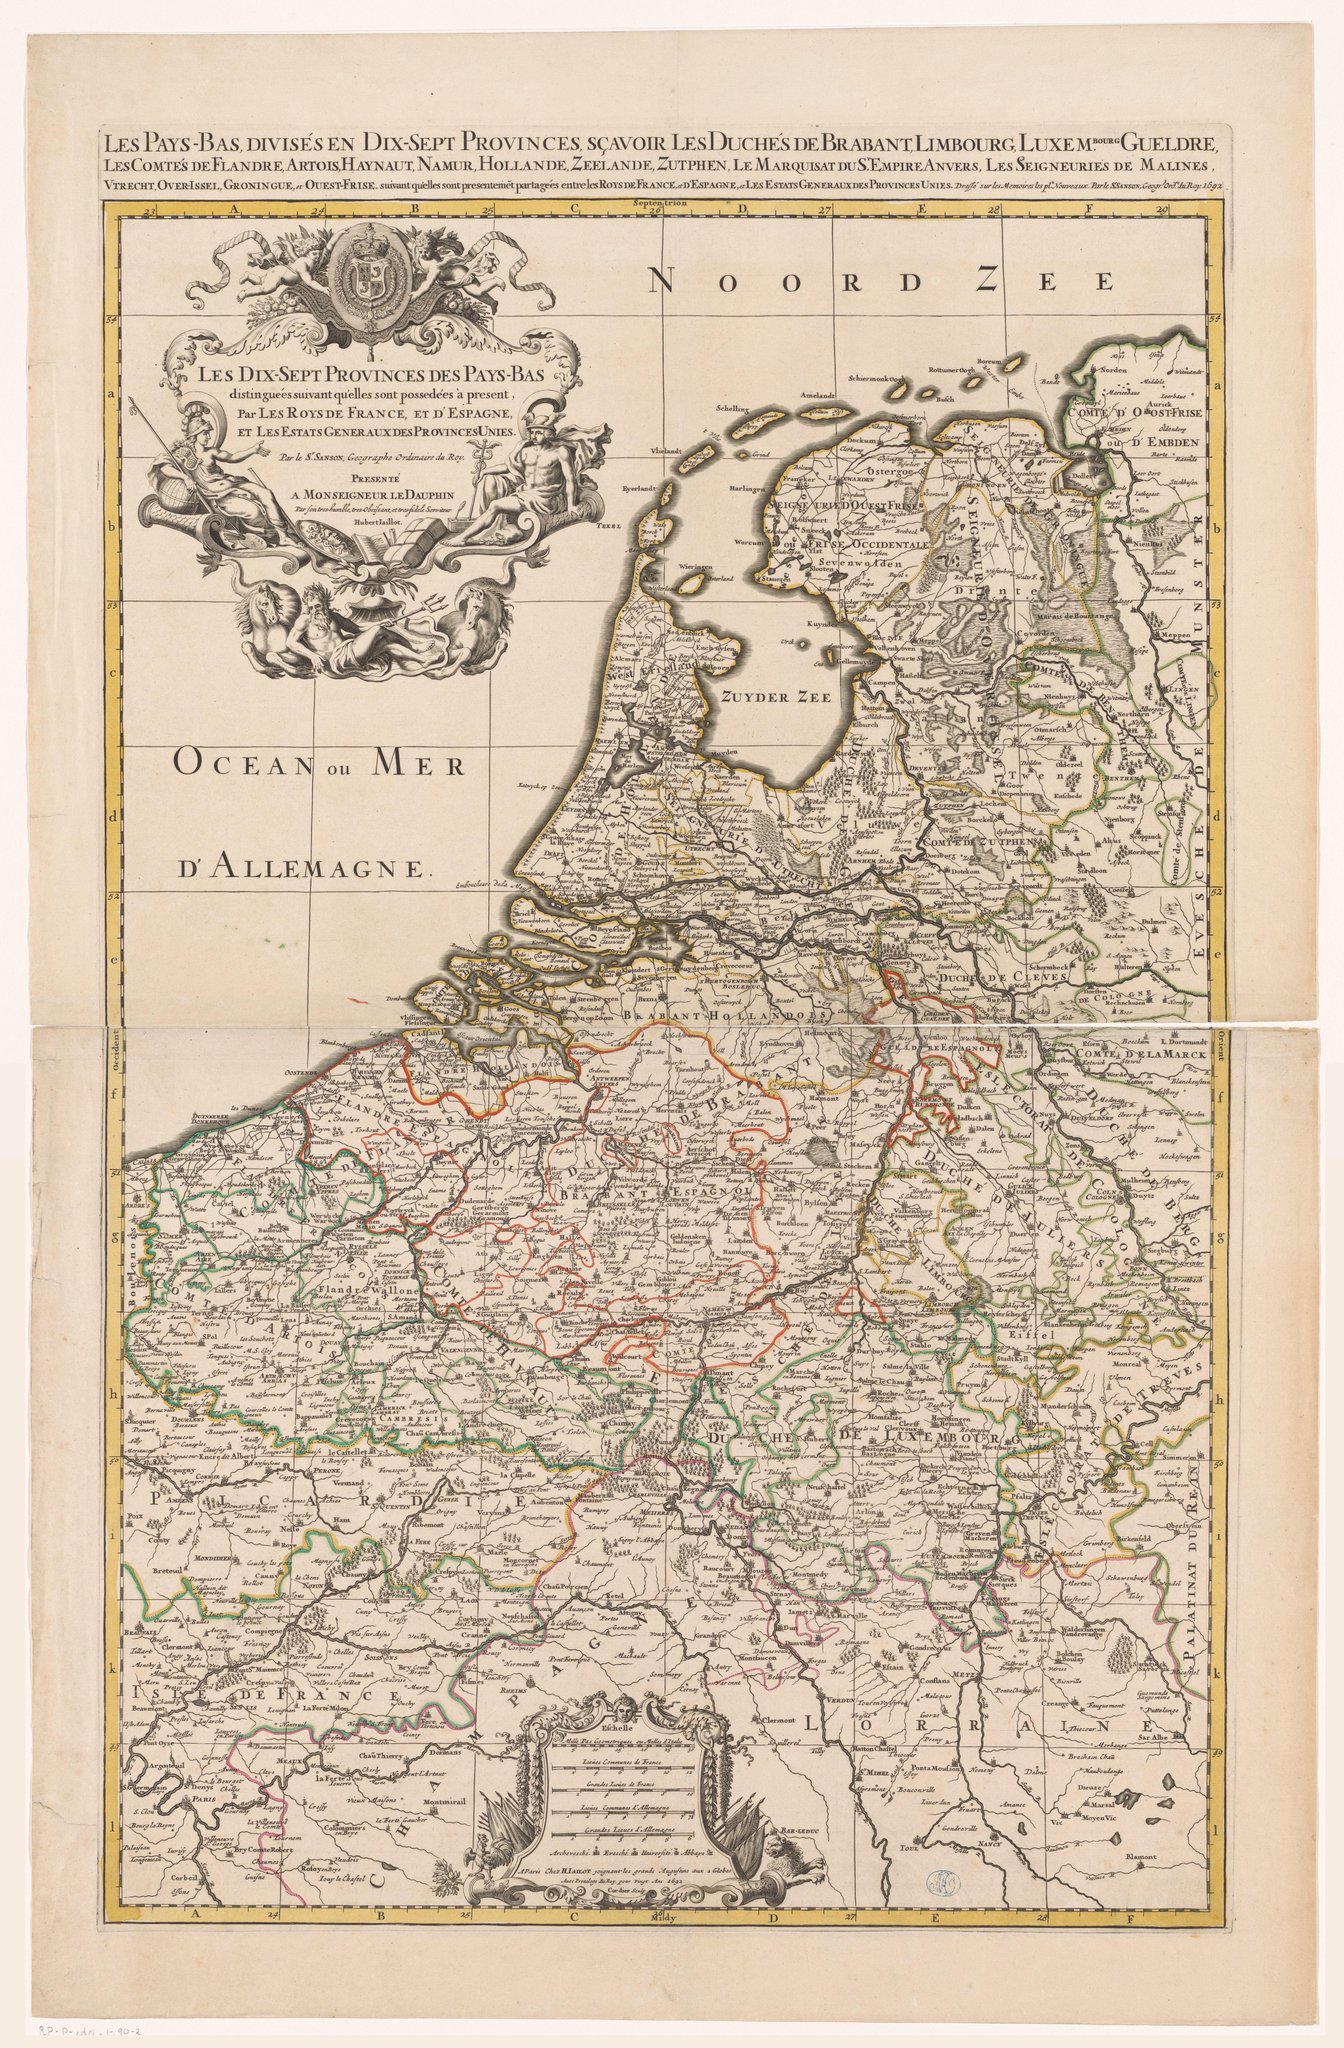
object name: map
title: Kaart van de Zeventien Provinciën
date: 1690-1692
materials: paper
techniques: engraving, hand coloring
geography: amsterdam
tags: (story of) neptune (poseidon), coat of arms (as symbol of the state, etc.), maps of separate countries or regions, (story of) minerva (pallas, athena), (story of) mercury (hermes), bony fishes: hippocampus - ff - fabulous animals (sometimes wrongly called 'grotesques'); 'mostri' (ripa), low countries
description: Linksboven titelcartouche met daaromheen het wapen van de dauphin van Frankrijk, twee putti, Minerva, Mercurius, Neptunus en twee zeepaarden. Onderaan legenda en schaalstok: Mille pas geometriques ou milles d'Italie, Lieües communes de France, en nog drie andere. De kaart is voorzien van een zoekrooster en een gradenverdeling langs de randen.